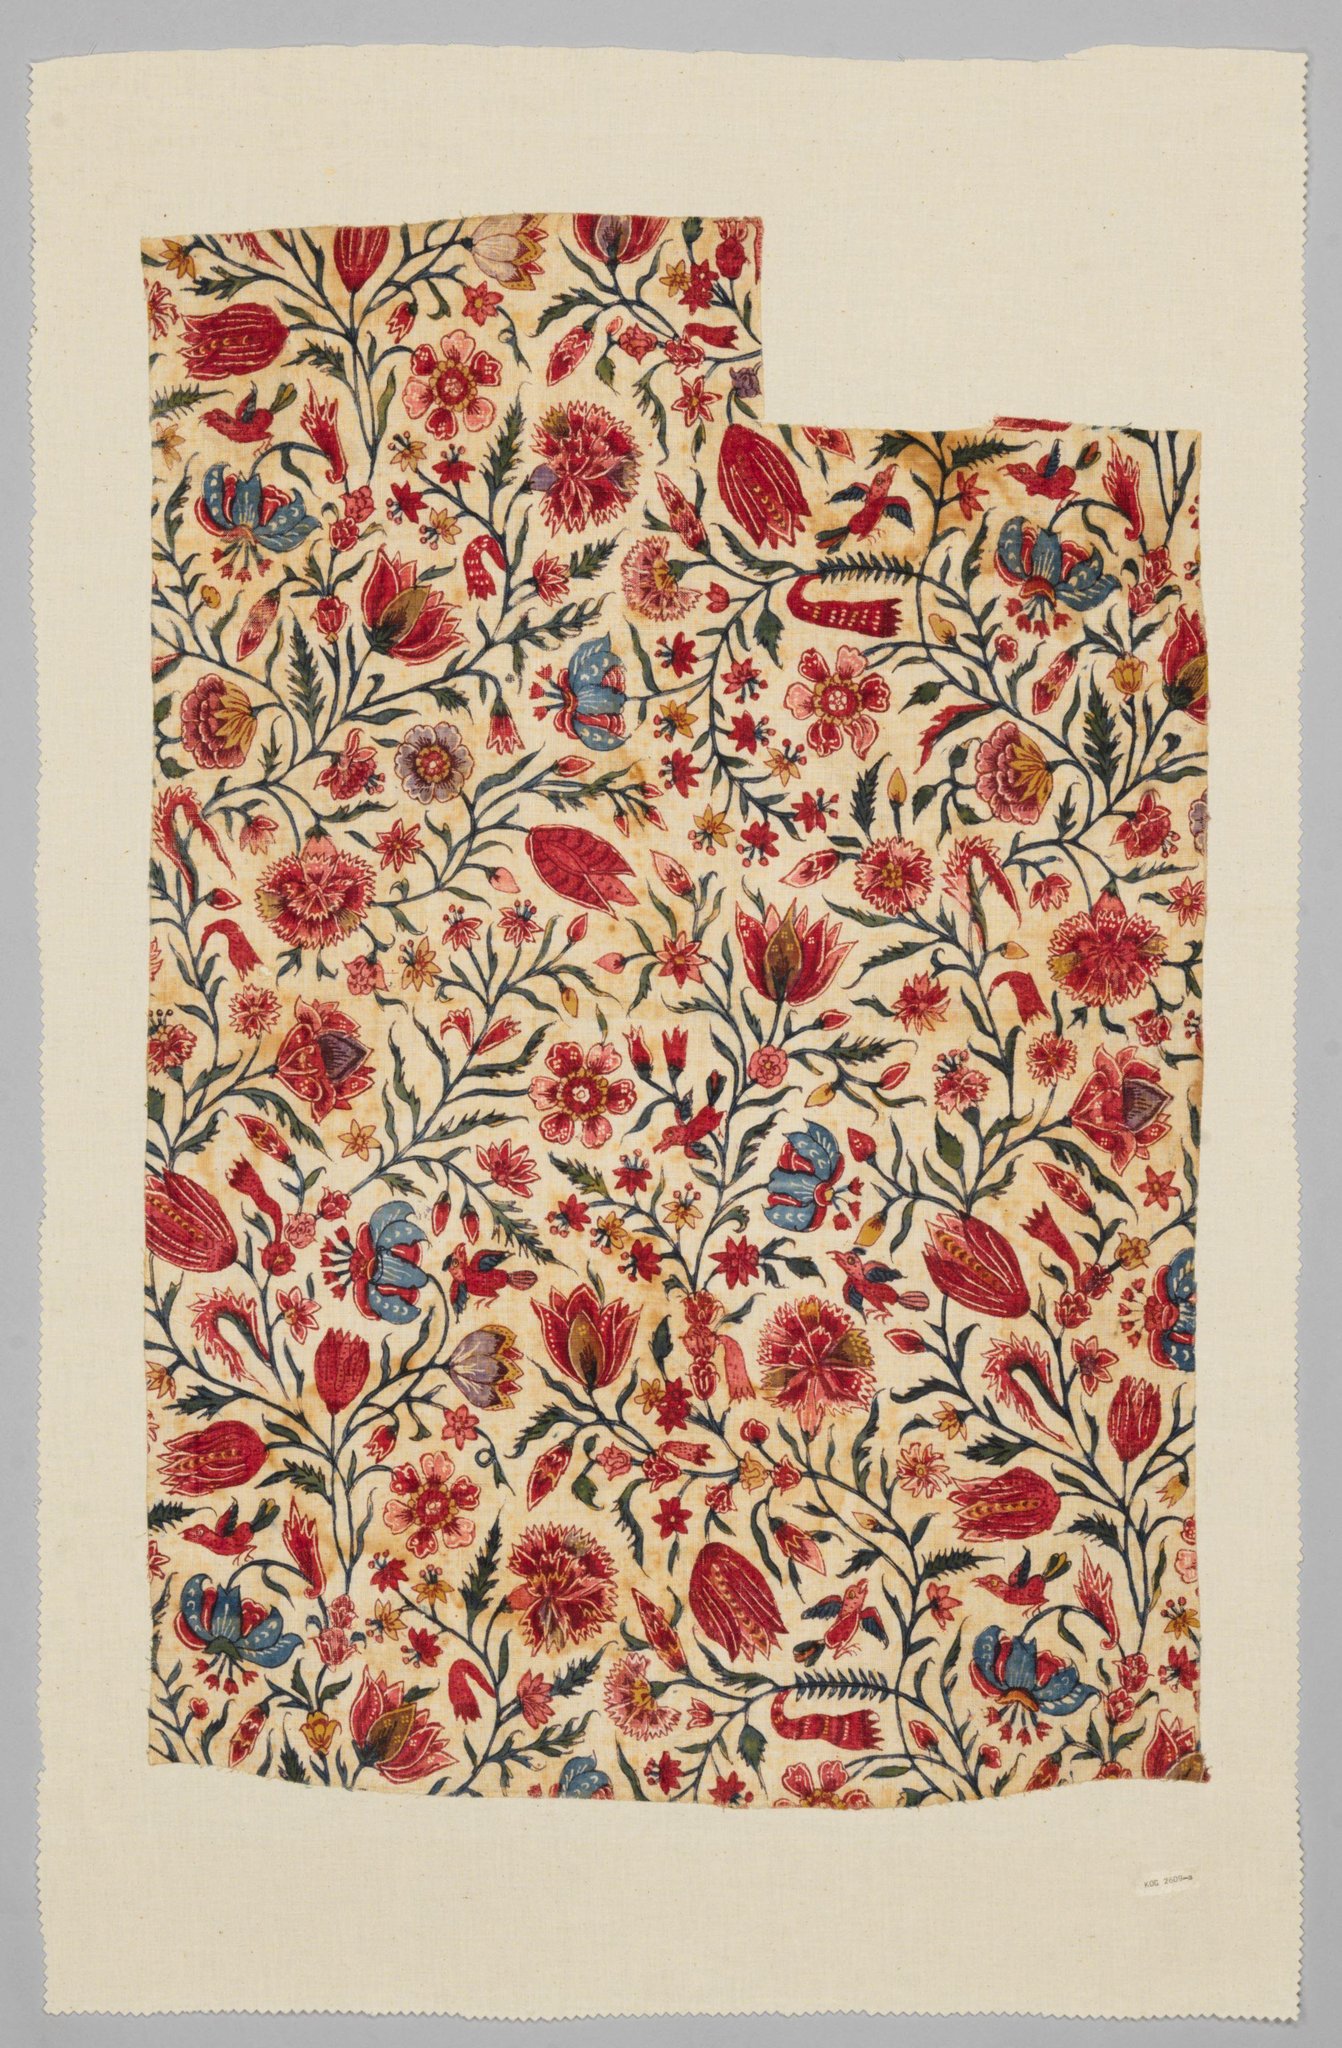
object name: fragment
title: Fragment sits met kolibri's.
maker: Anonymous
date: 1750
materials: textile, cotton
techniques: printing, weave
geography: coromandel coast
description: Fragment van sits met decoratie op vrij grove ondergrond van breed golvende opgaande ranken van indigo blauw, begeleid door zijranken. Deze eindigen in grote bloemen als tulpen en anjers in rood met geel, blauwe bloemen met teruggeslagen kroonbladeren, rozetbloemen in rose en rood, ranonkelachtigen van kraplak met geel etc. Daartussen fijne bloemen met kolibri's. Op stuk linnen gezet.